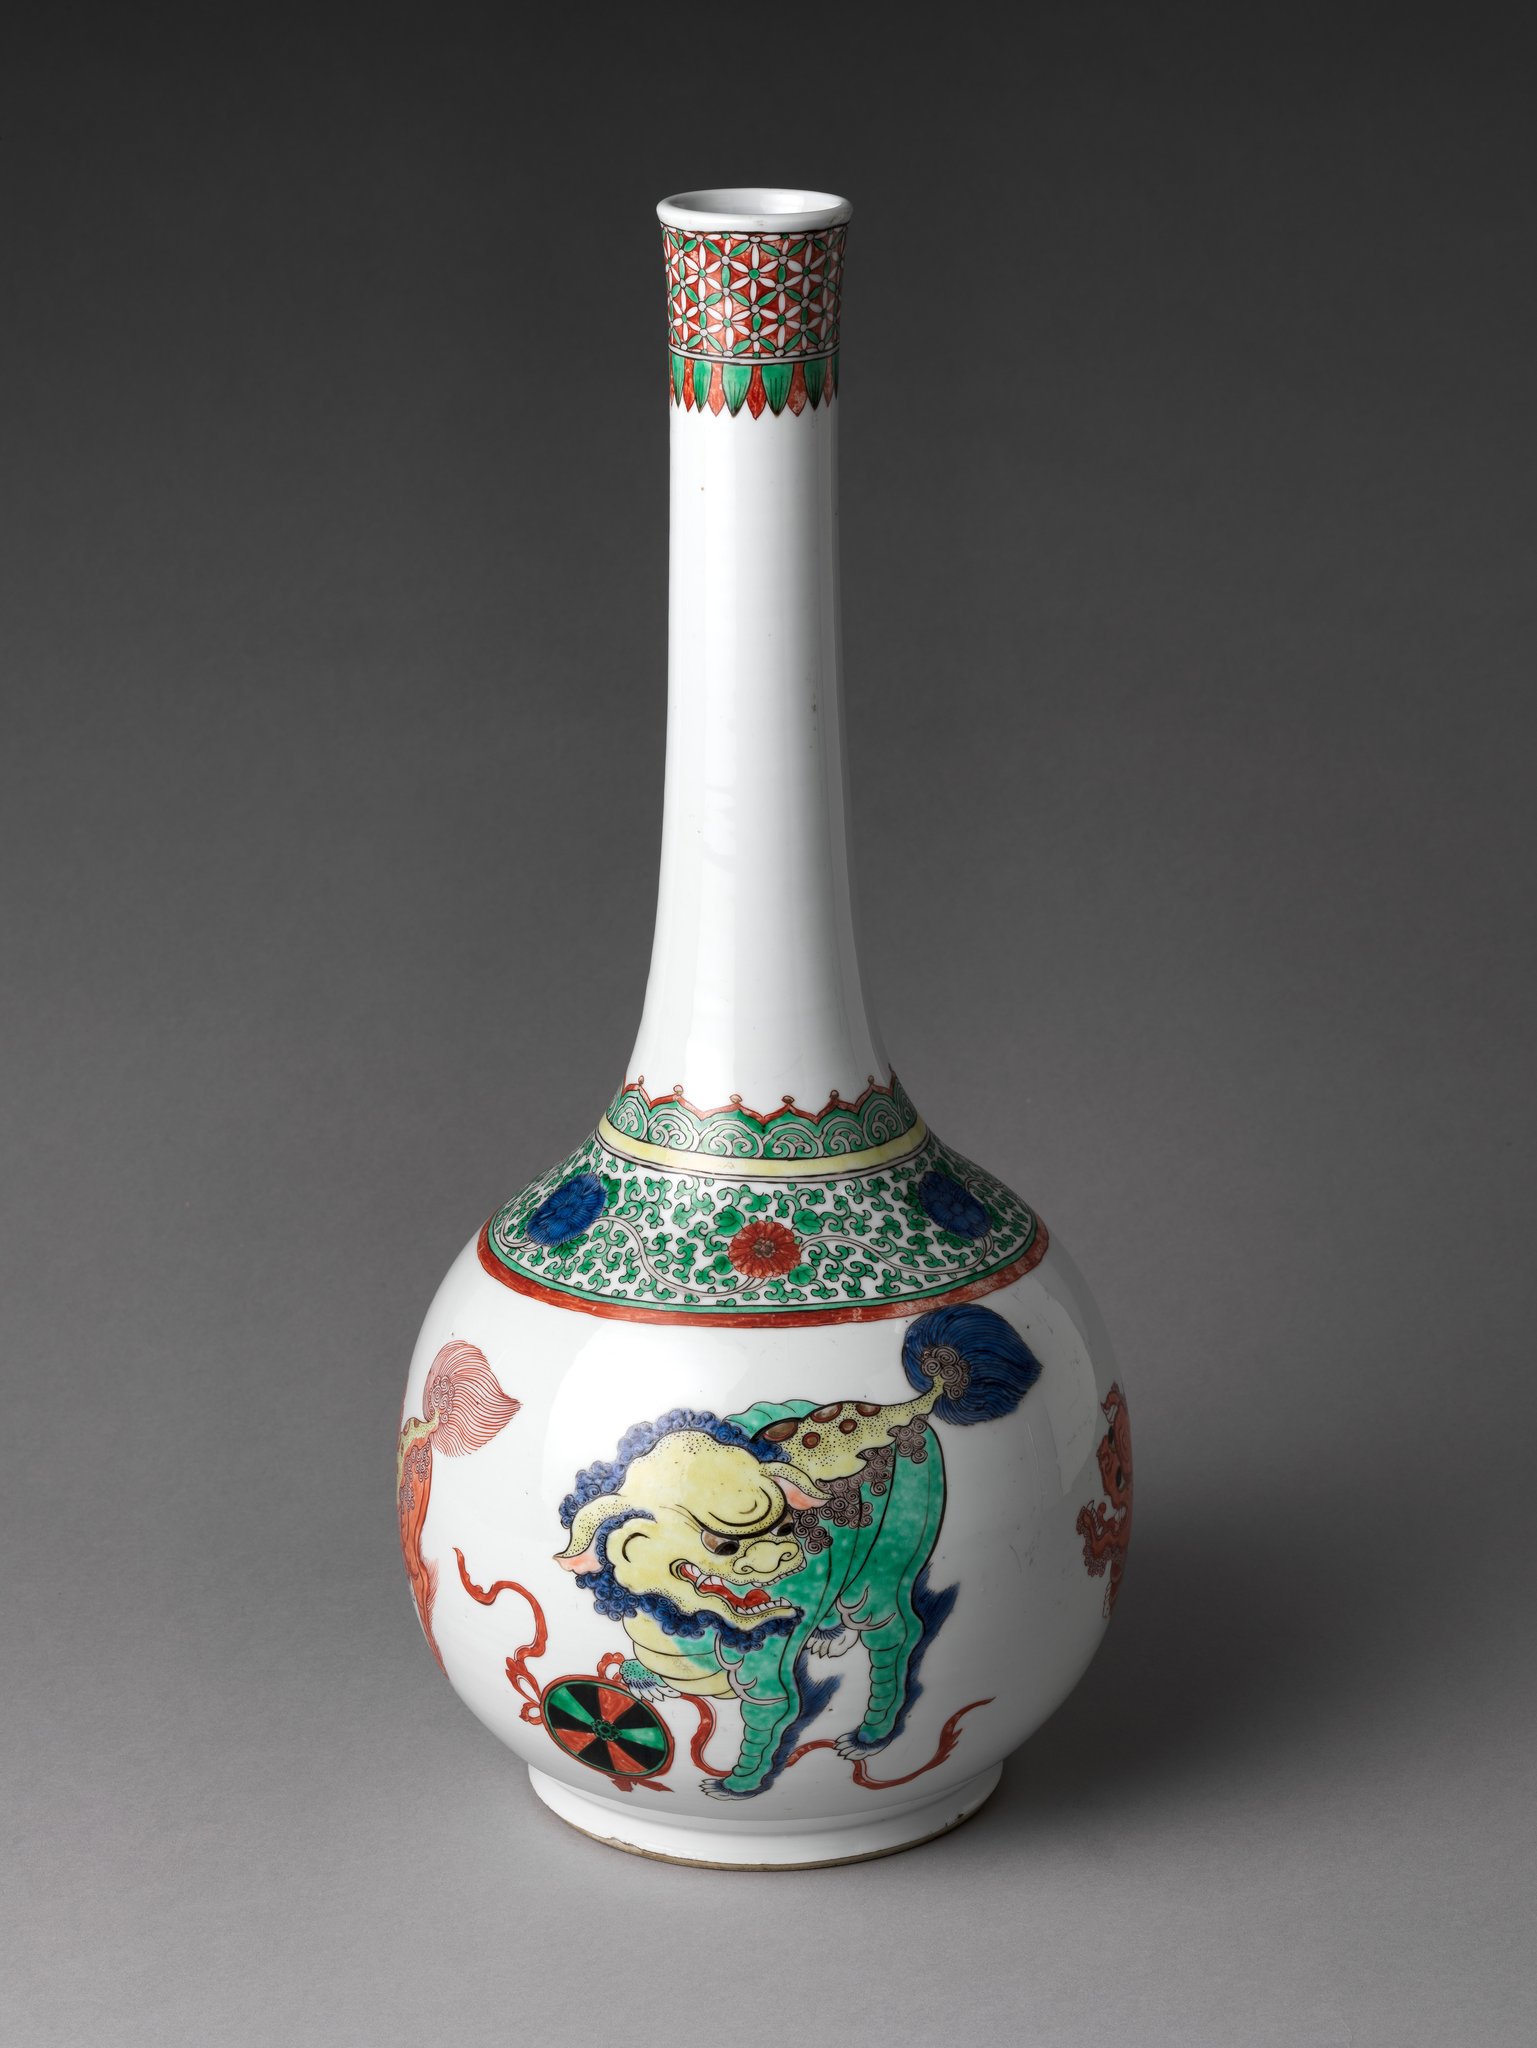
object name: bottle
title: Bottle with Lion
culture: chinese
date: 1701-1733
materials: enamel, glaze, porcelain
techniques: painting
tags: lions